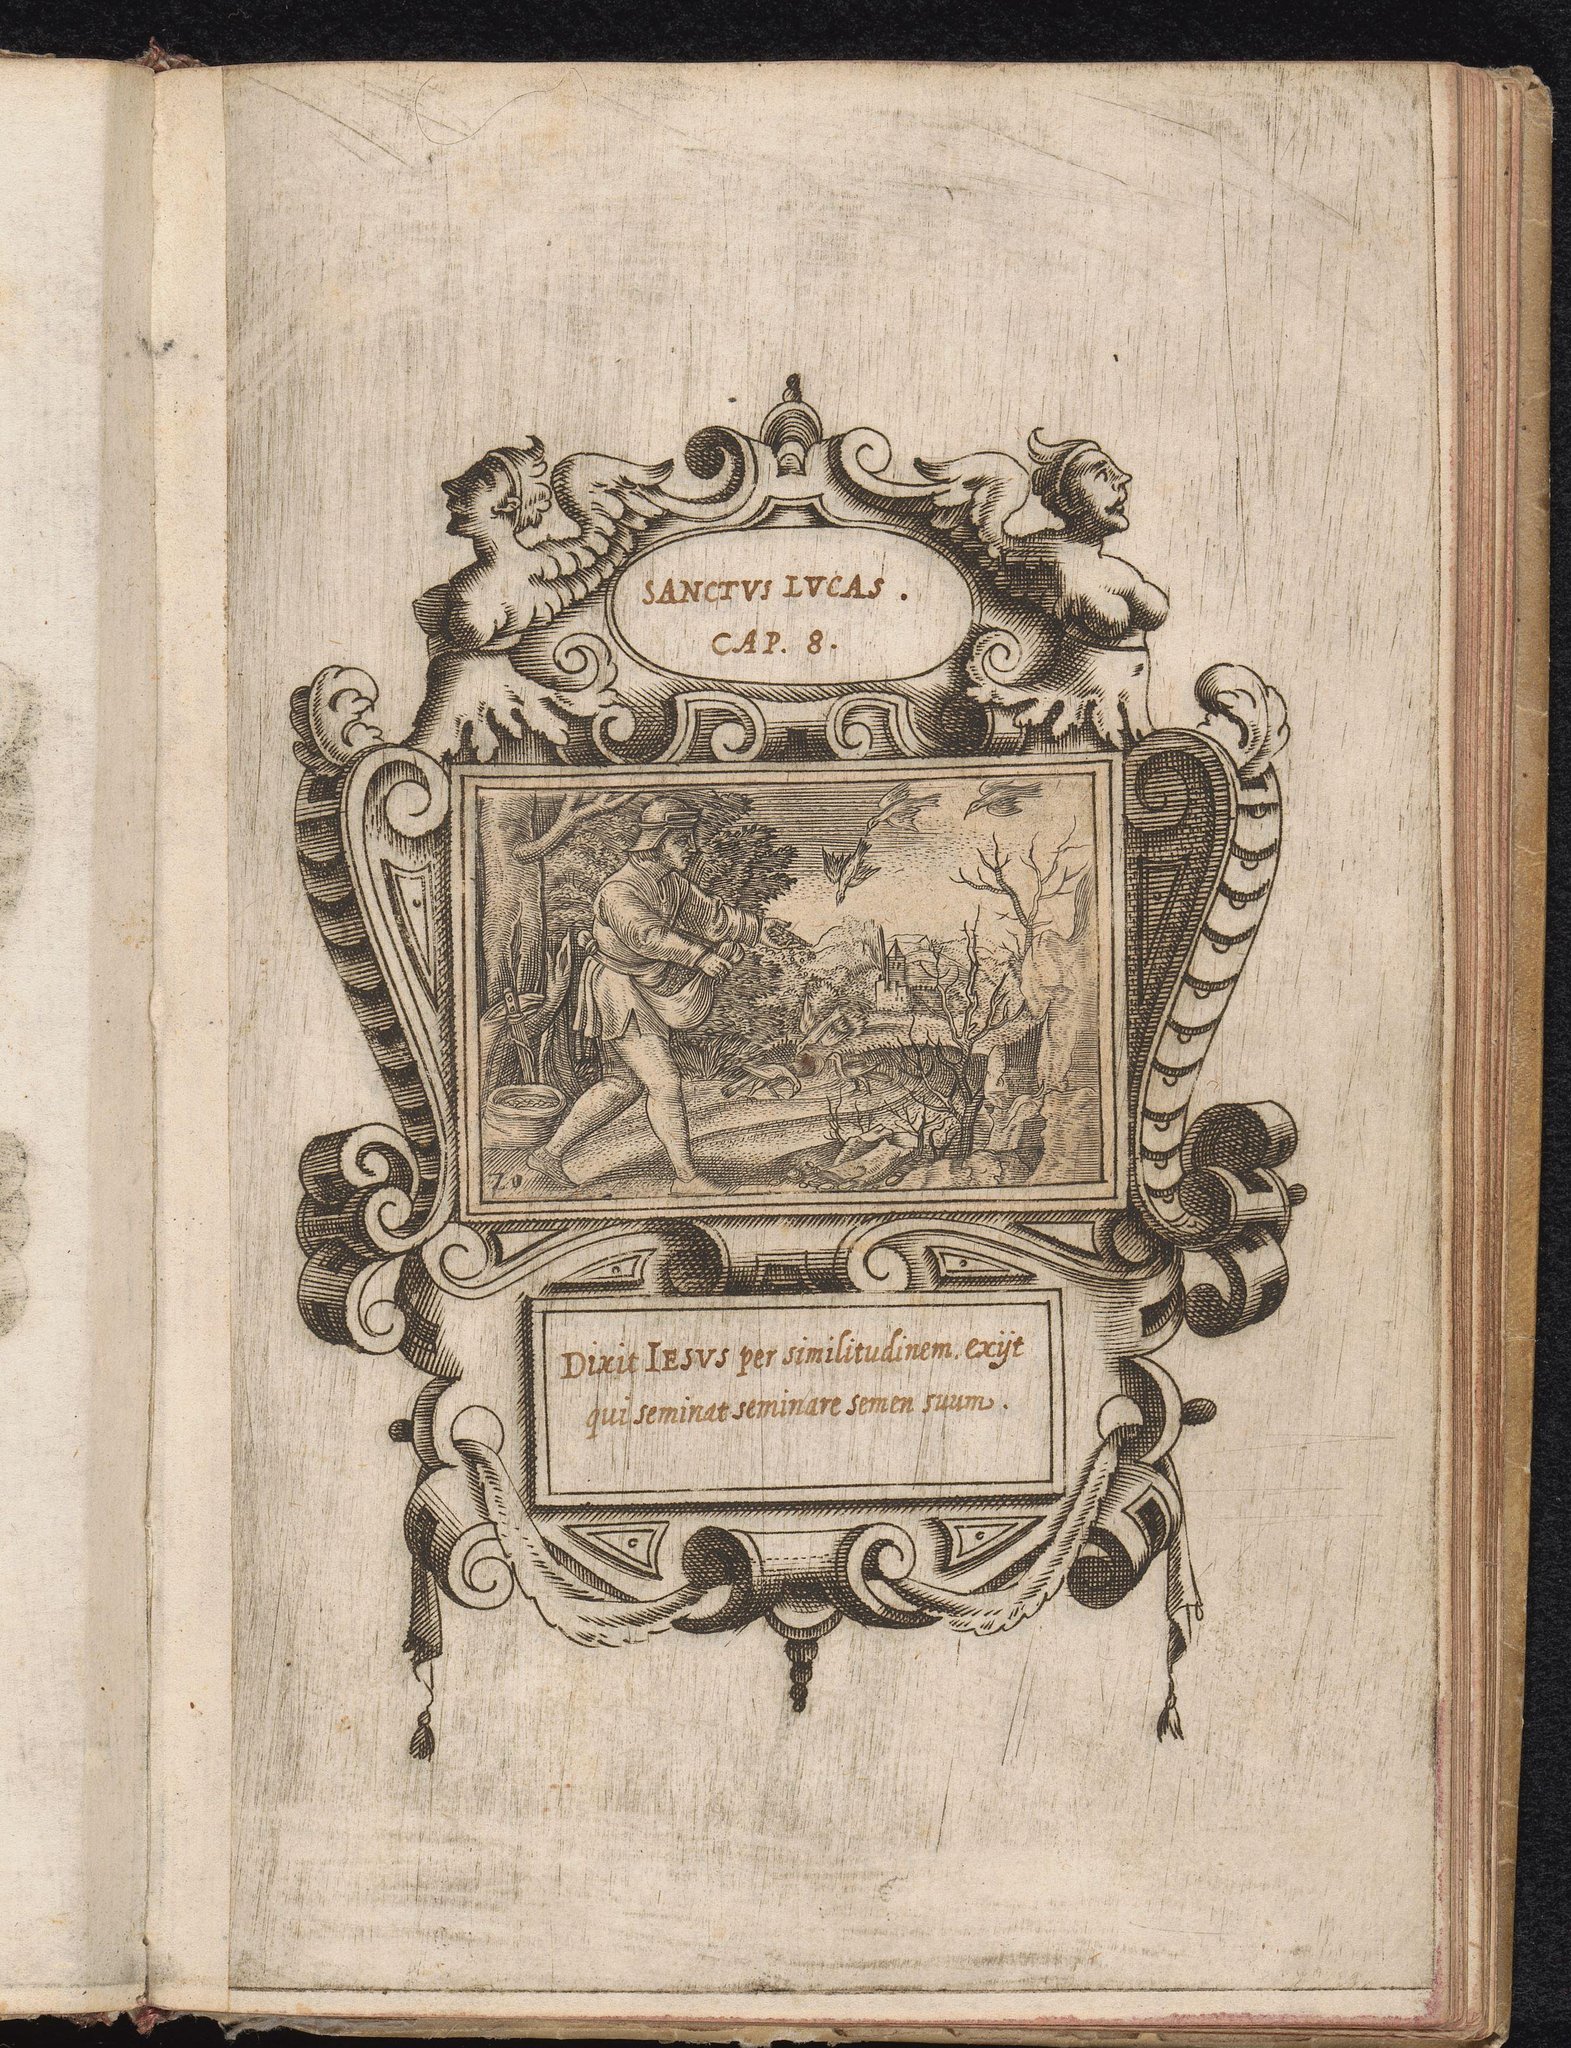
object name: print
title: Parabel van de zaaier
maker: Anonymous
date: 1570-1610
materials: paper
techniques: engraving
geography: antwerp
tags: the sower ~ parable of christ (matthew 13:3-9; mark 4:3-9; luke 8:5-8)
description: Parabel van de zaaier. Onderdeel van een prentalbum met titelprent en 56 scènes uit het Nieuwe Testament. Elke voorstelling gemonteerd in een gravure met ornamentele cartouches waarin een venster is gesneden en voorzien van handgeschreven bijbelpassages.